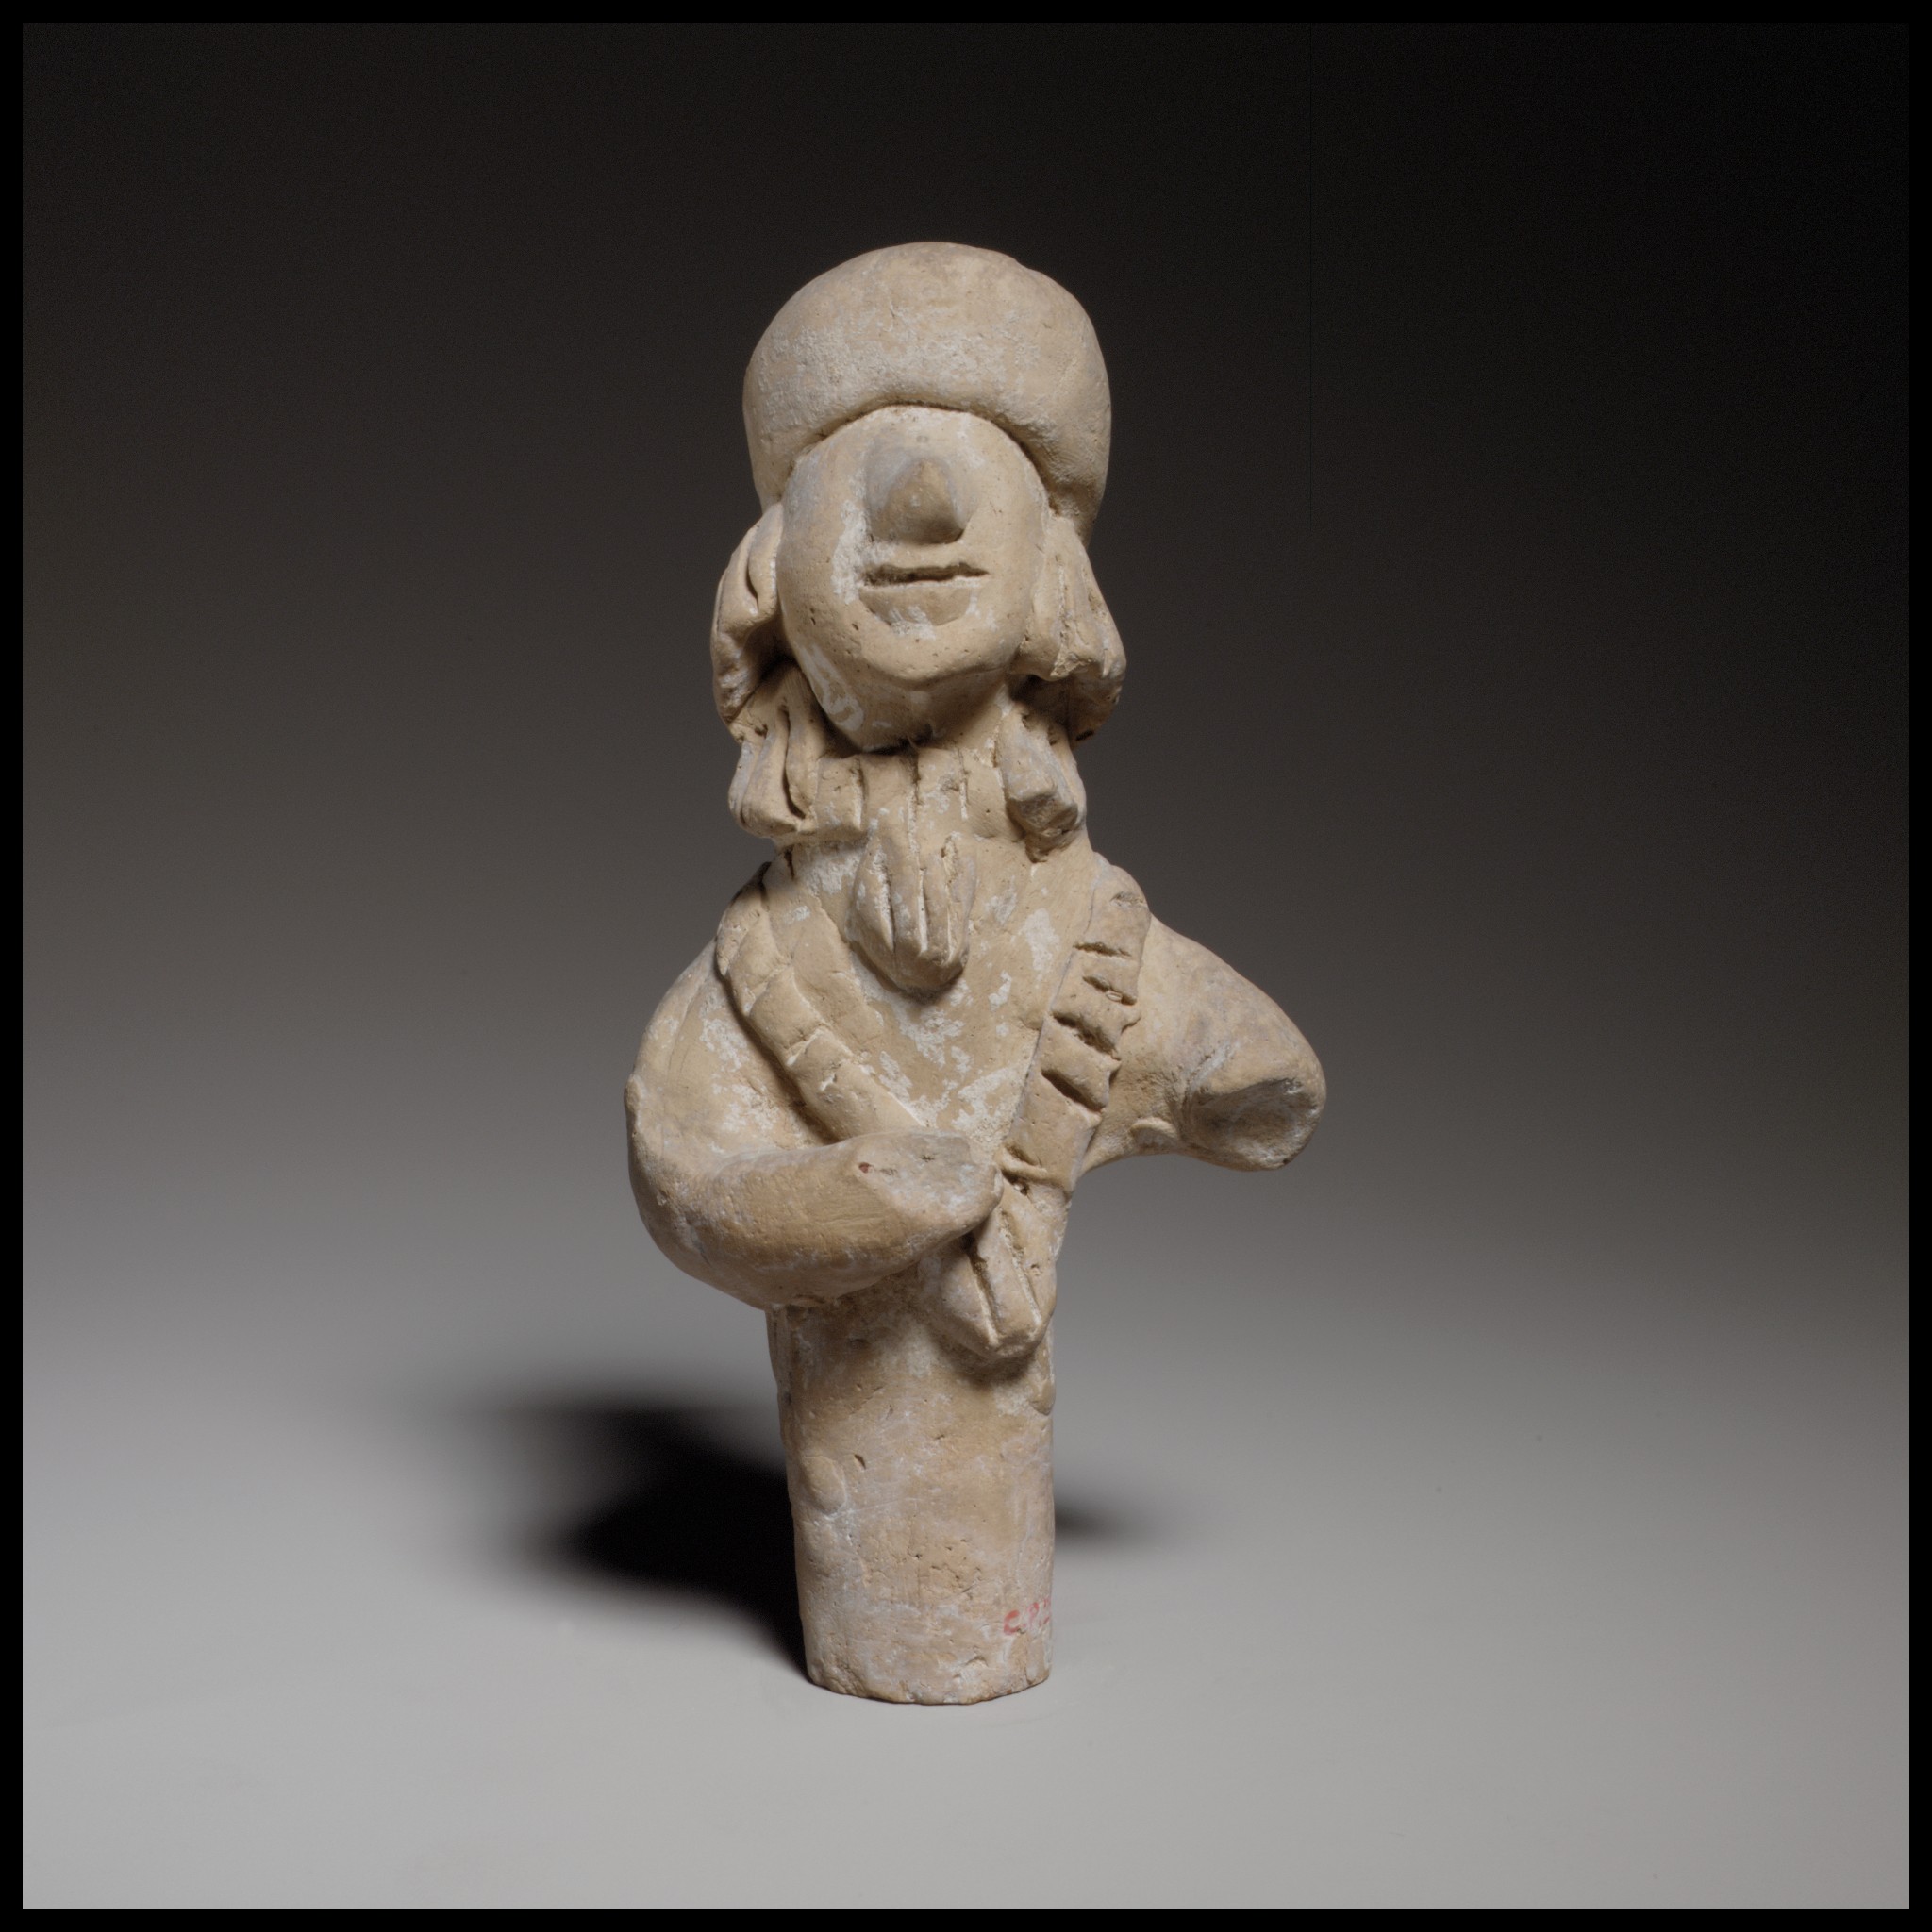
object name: statuette of a woman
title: Terracotta statuette of a woman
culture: cypriot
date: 600-480 BCE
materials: terracotta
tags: women